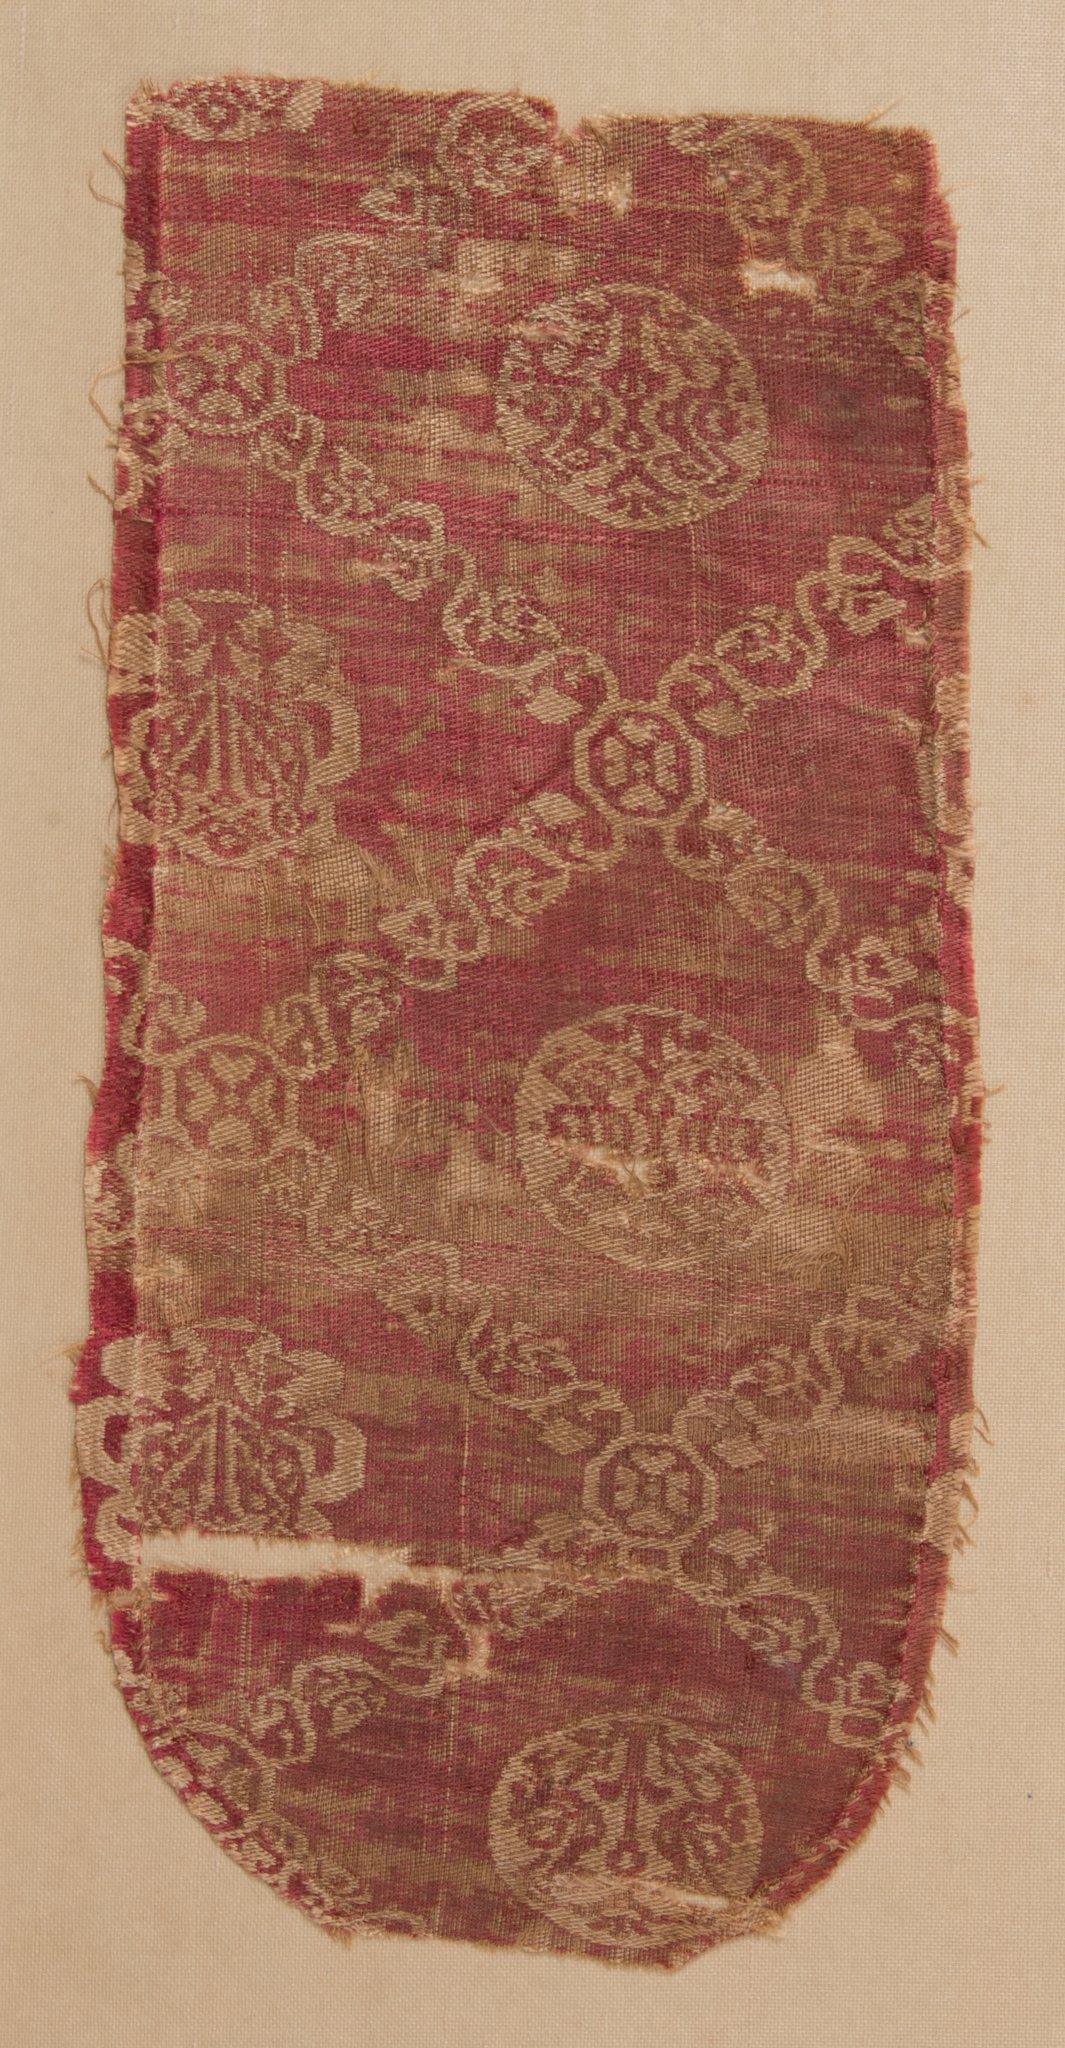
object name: textile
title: Textile with Diaper Pattern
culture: egyptian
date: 501-900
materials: silk